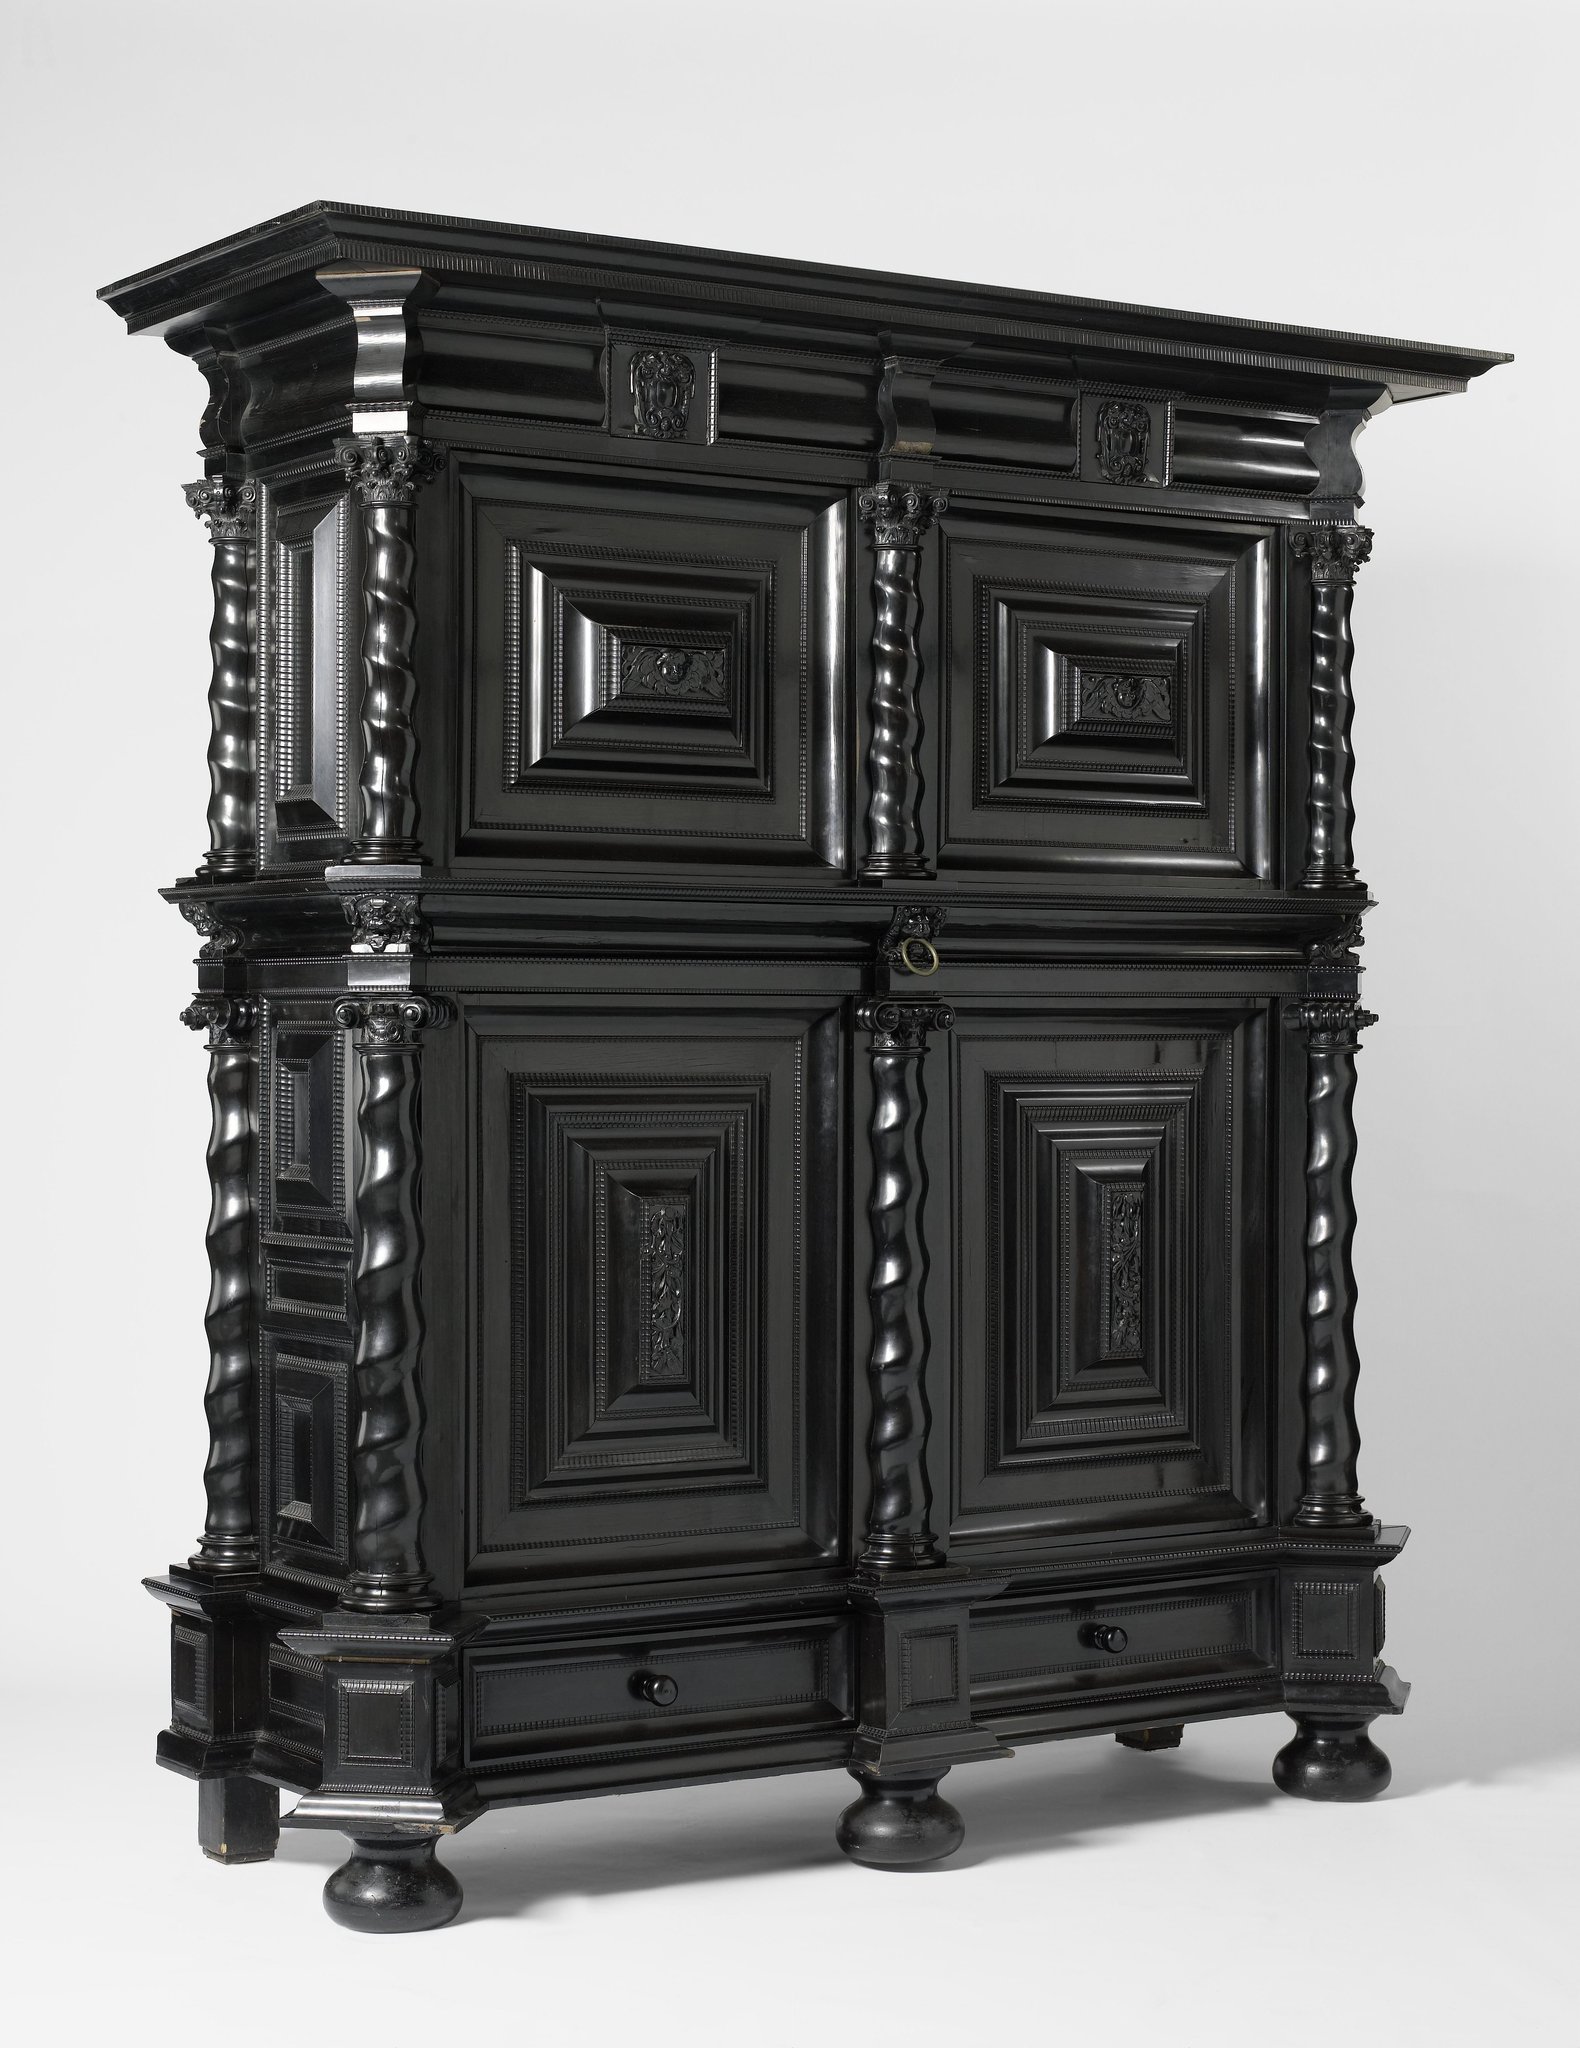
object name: kussenkast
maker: Anonymous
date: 1650-1670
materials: wood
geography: netherlands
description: Kast op bolpoten, belijmd met ebbenhout op eikenhouten kern. De, op de hoeken en in het midden met maskers versierde, lade maakt een tweedeling. De onderkast heeft onderin twee laden en twee hoge deuren met kussens, versierd met festoenen; de kussens van de lage bovendeuren met cherubkoppen. Op de overhoeks geplaatste hoekstijlen en de middenstijl getordeerde zuilen, boven met Corinthische en onder met Ionische kapitelen. Verkroppingen bij de zuilen. Dubbel ojiefvormig fries met cartouches. Robbellijsten.